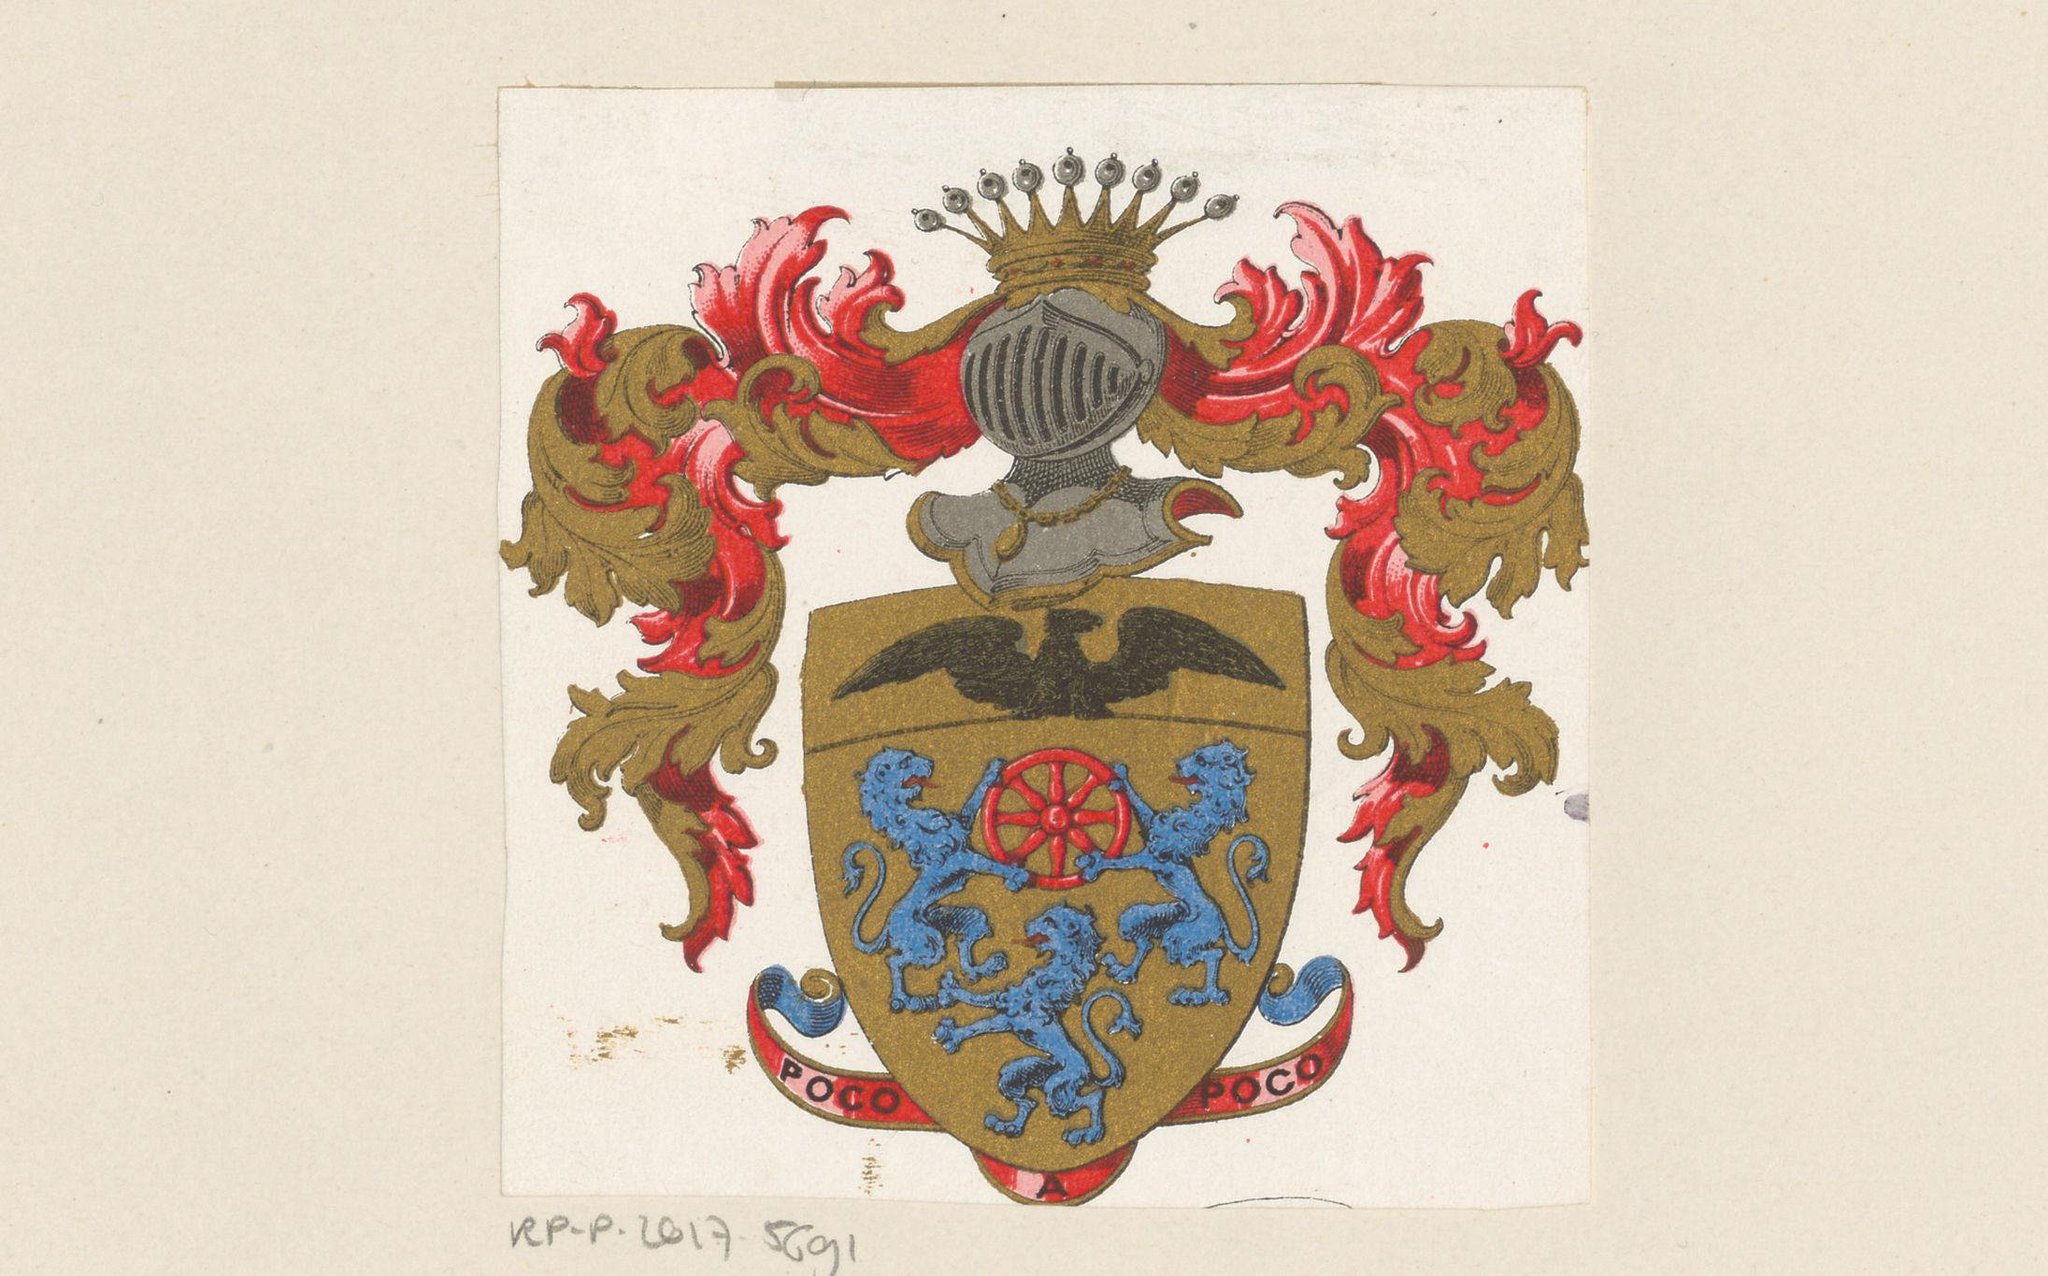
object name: bookplate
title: Ex libris van onbekend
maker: Anonymous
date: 1850-1924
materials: paper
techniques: printing block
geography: france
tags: armorial bearing, heraldry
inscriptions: inscription: ‘Ramage’